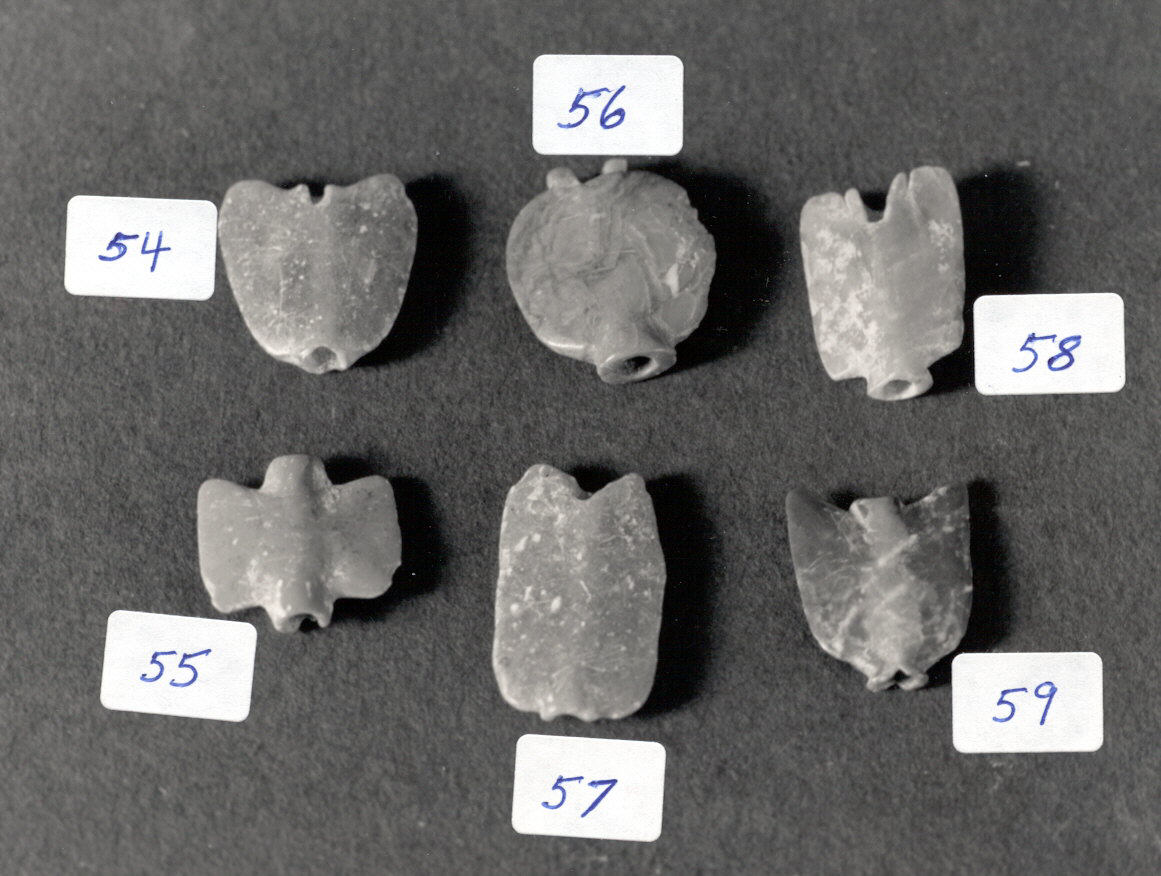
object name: bead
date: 7333-7001 BCE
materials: stone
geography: syria